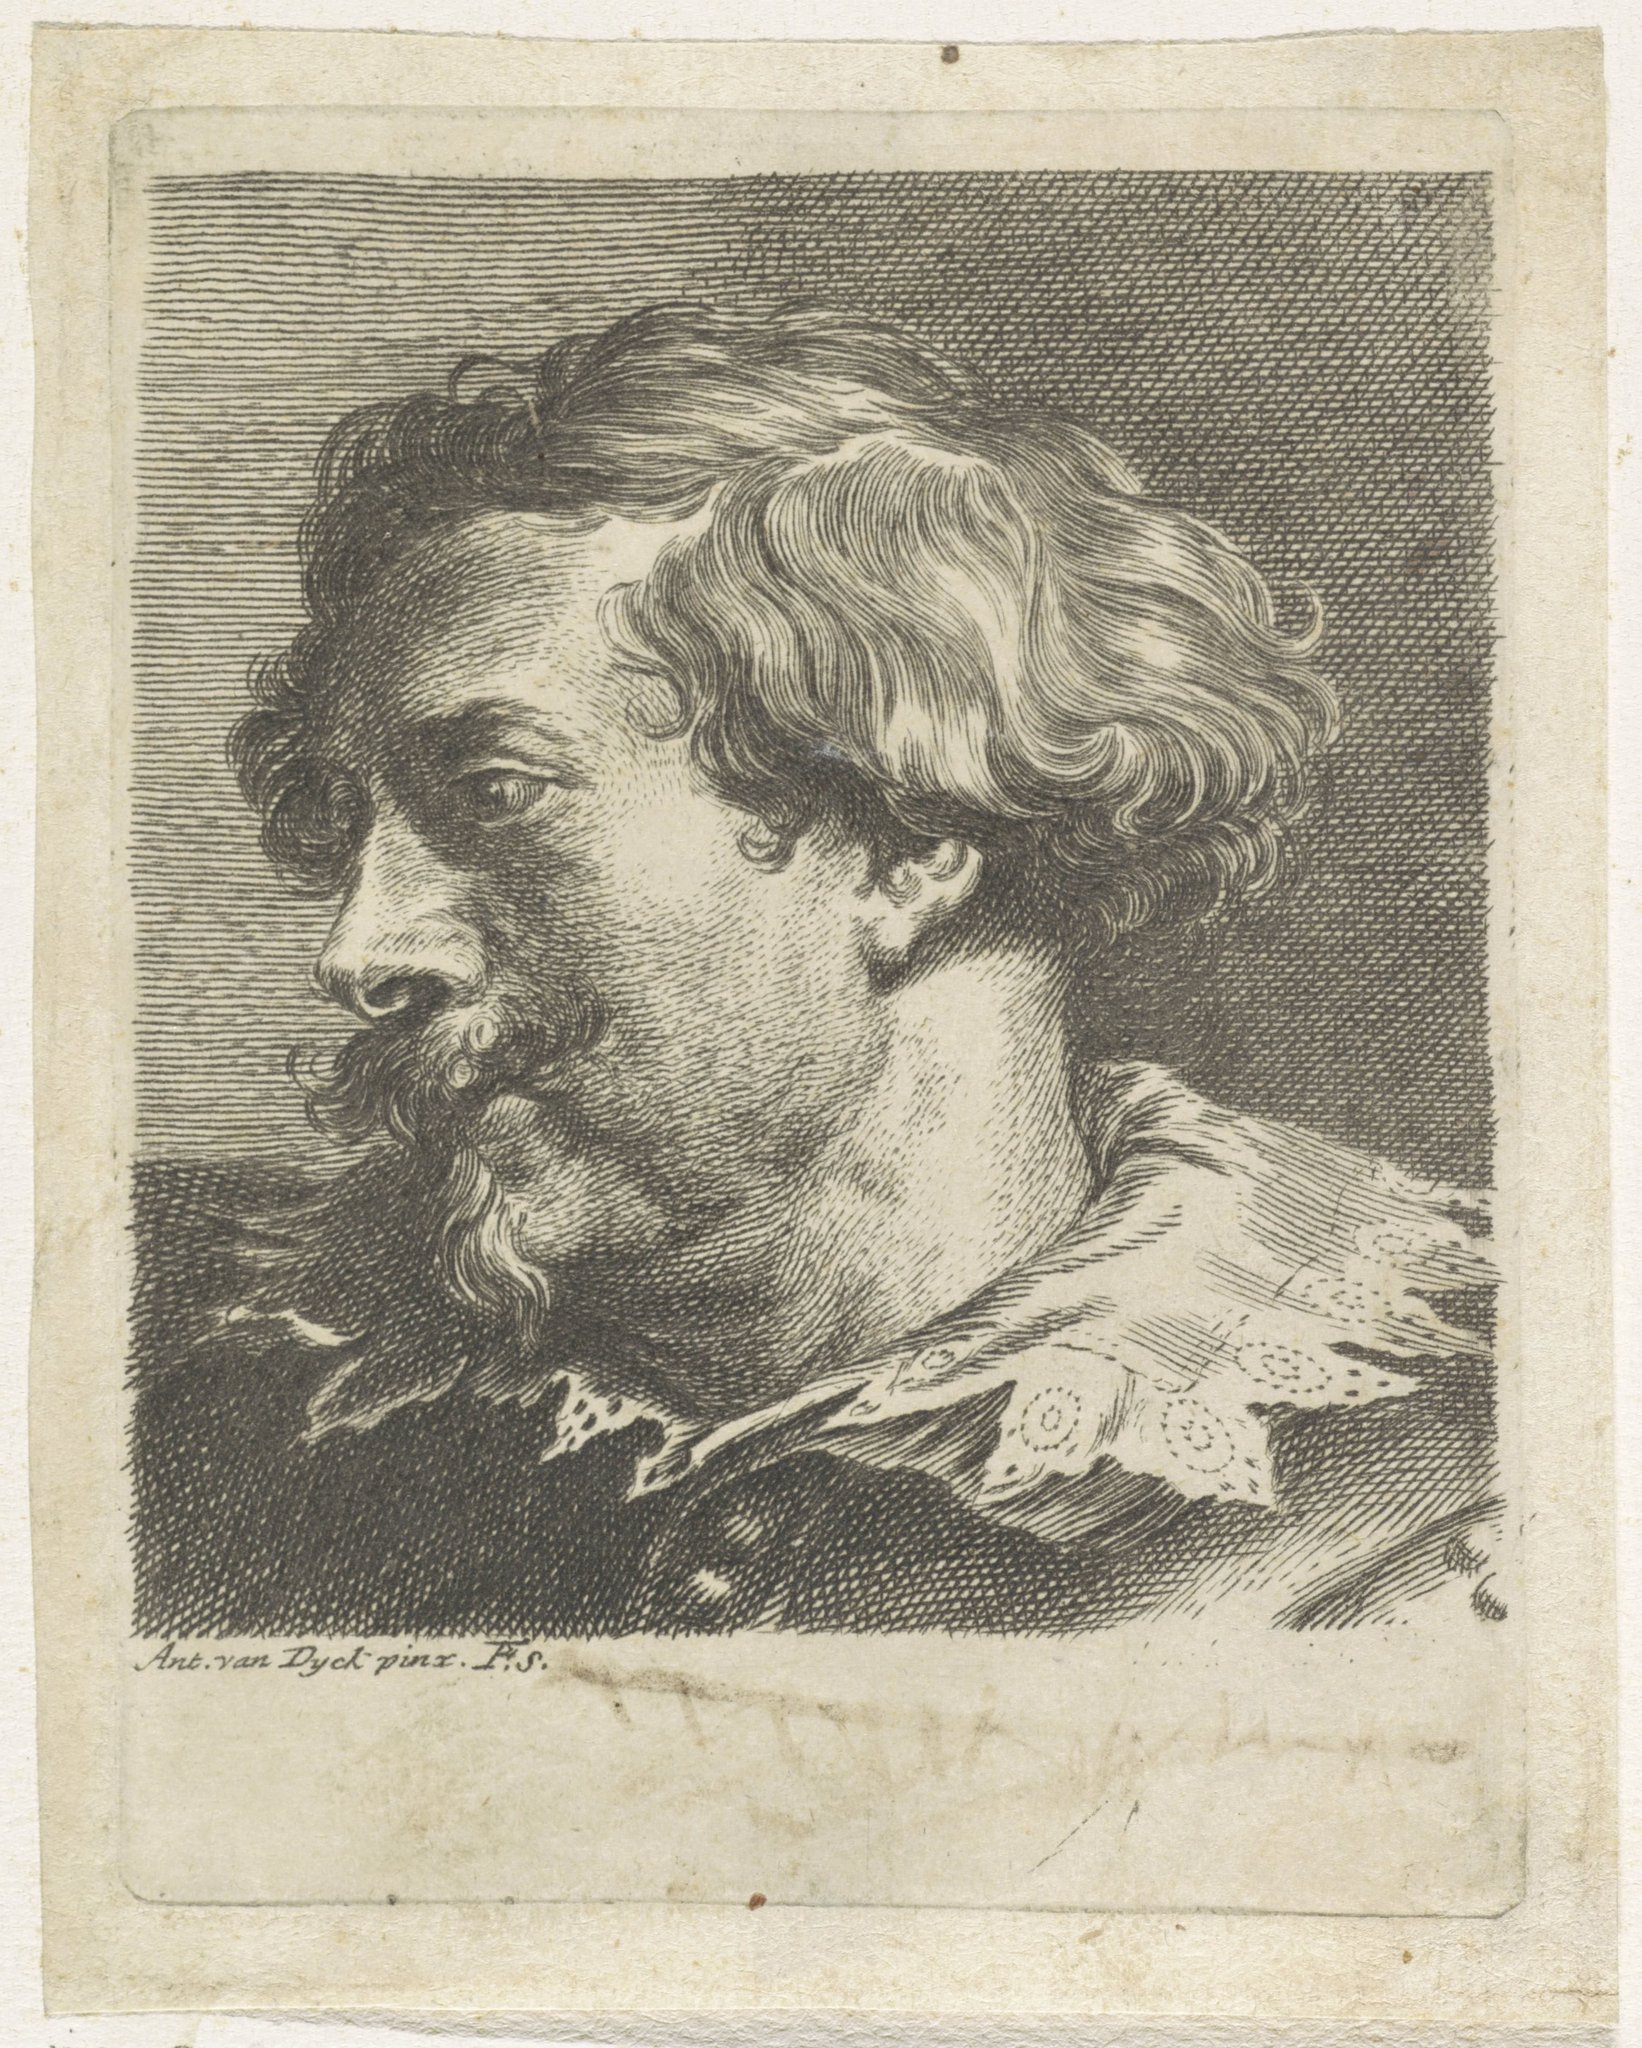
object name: print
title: Portret van Hubrecht van den Eynde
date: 1630-1650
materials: paper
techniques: engraving, etching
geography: antwerp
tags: antwerp, sculptor, portrait, self-portrait of sculptor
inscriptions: collector's mark: Lugt 2228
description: Portret van de Antwerpse beeldhouwer Hubrecht van den Eynde, naar links.